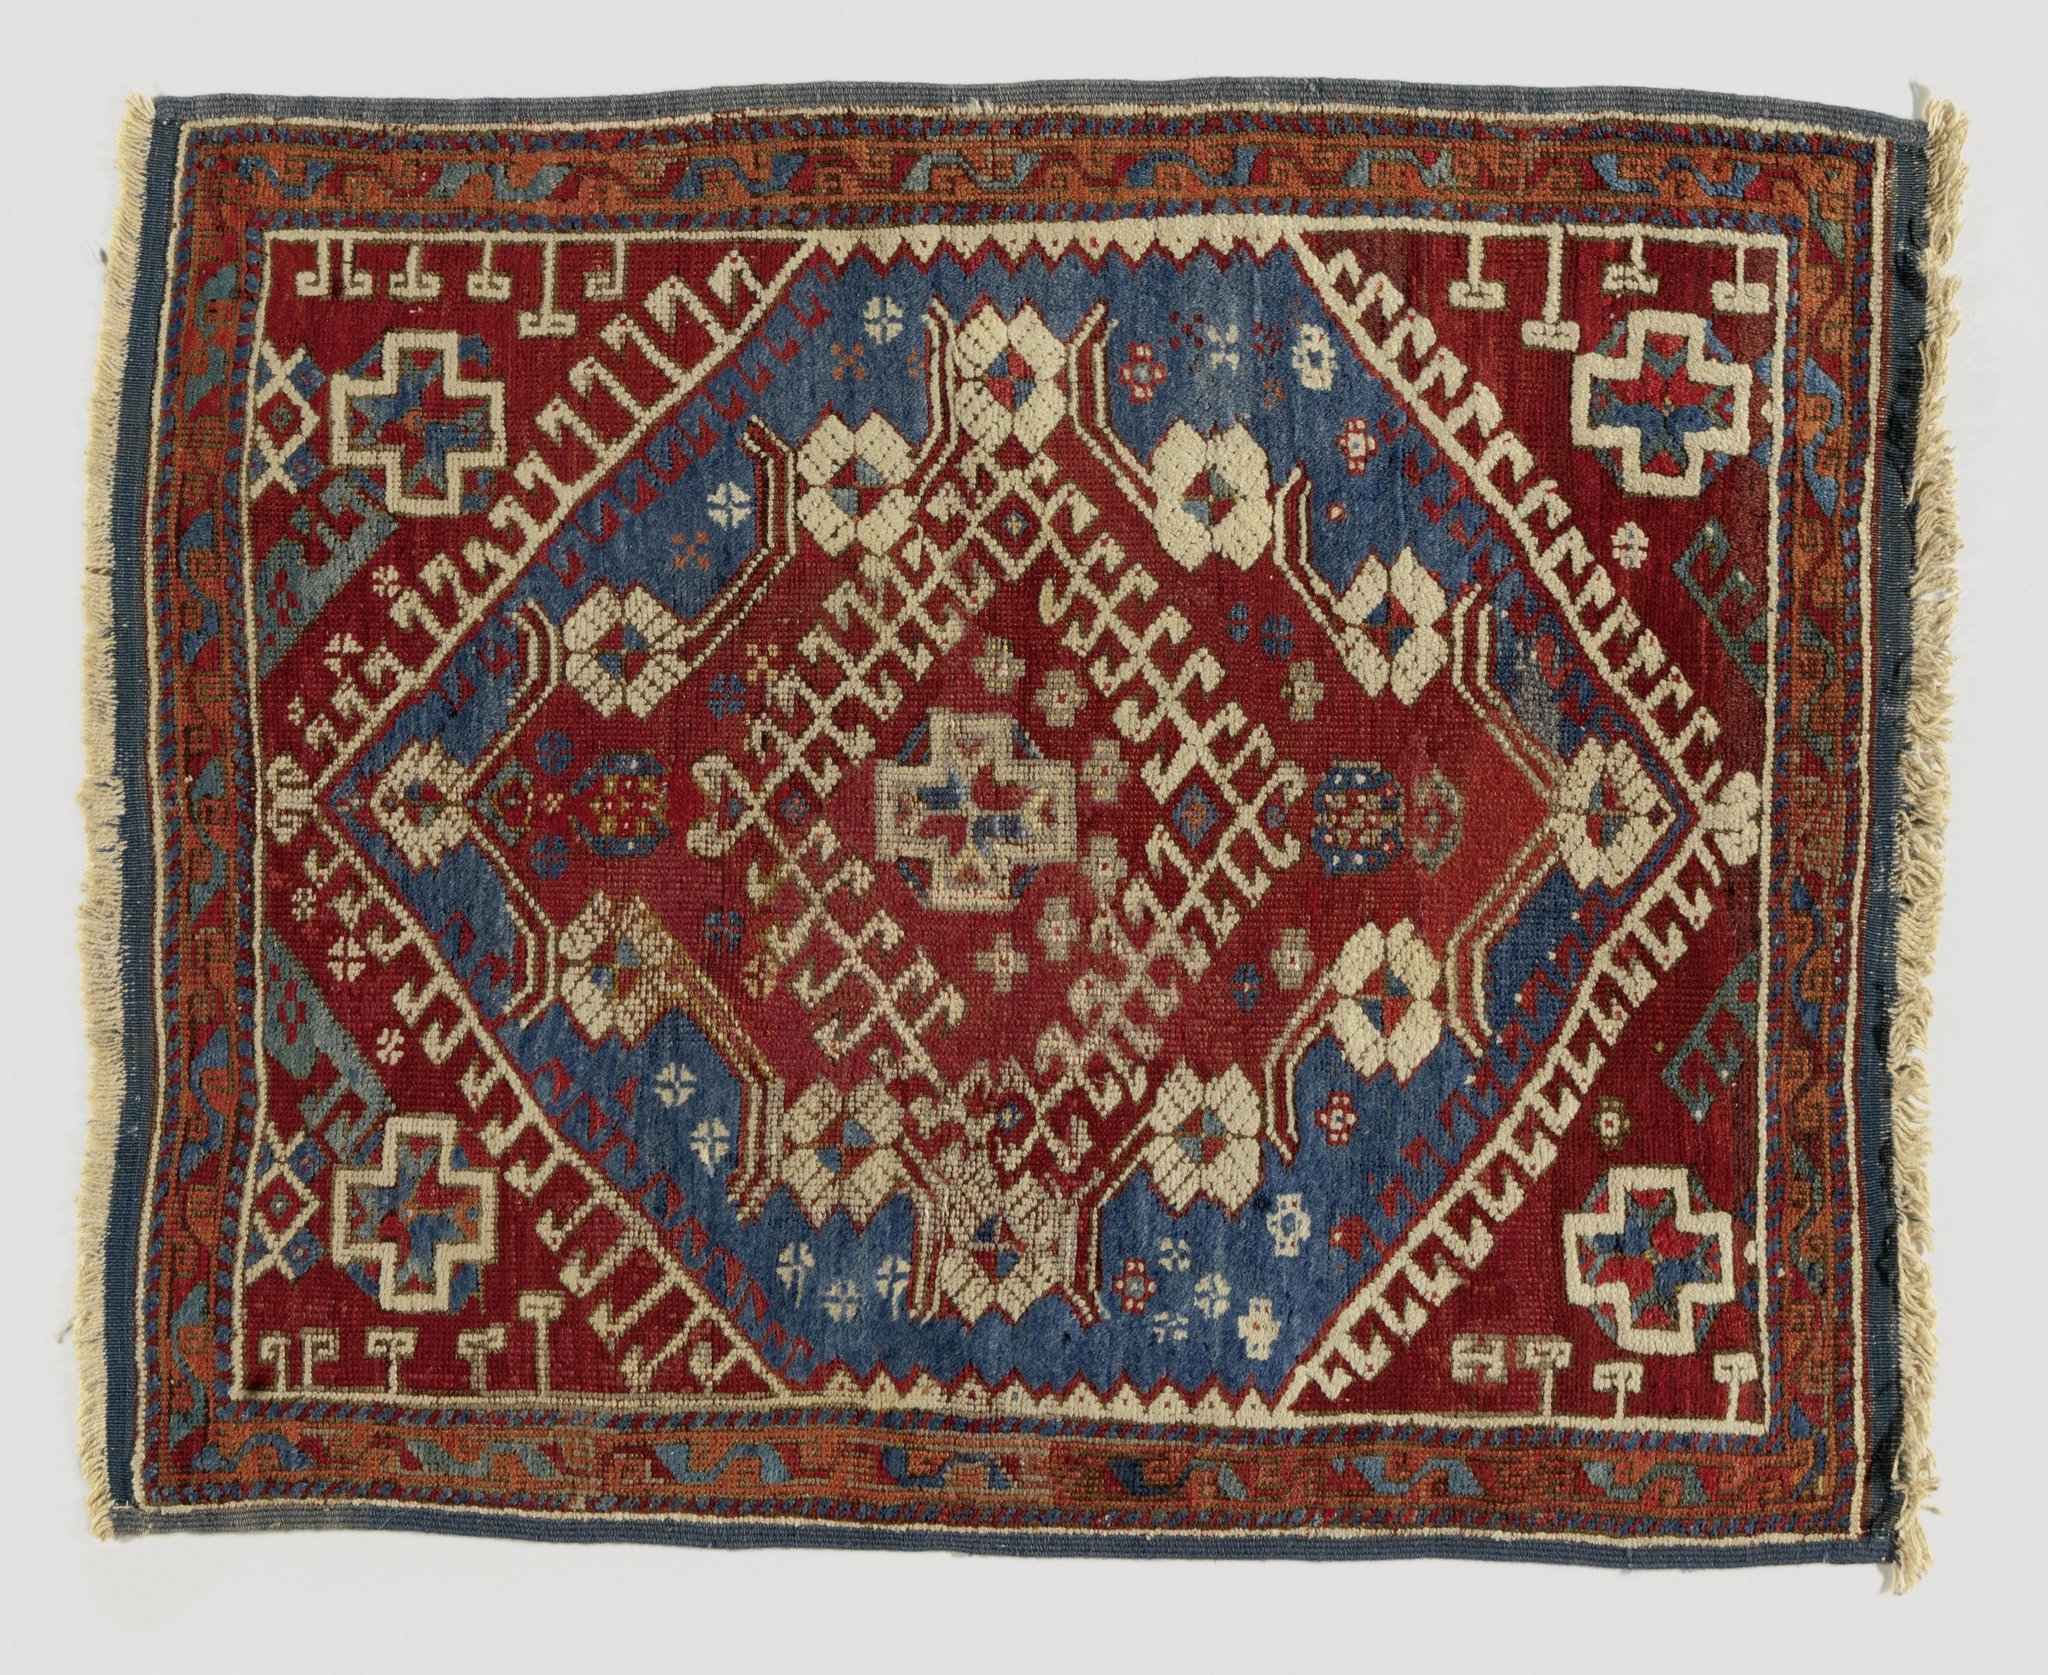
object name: oriental rug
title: Oosters tapijt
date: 1700-1900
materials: wool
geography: yagcibedir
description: Oosters tapijt, medaillonkleed. In het blauwe zeshoekig midden staat een concentrische ruit, omgeven door haken en stengels met rozetbloemen. In het hart een kruisvormige sterbloem. Knoop: Ghiordes knoop.